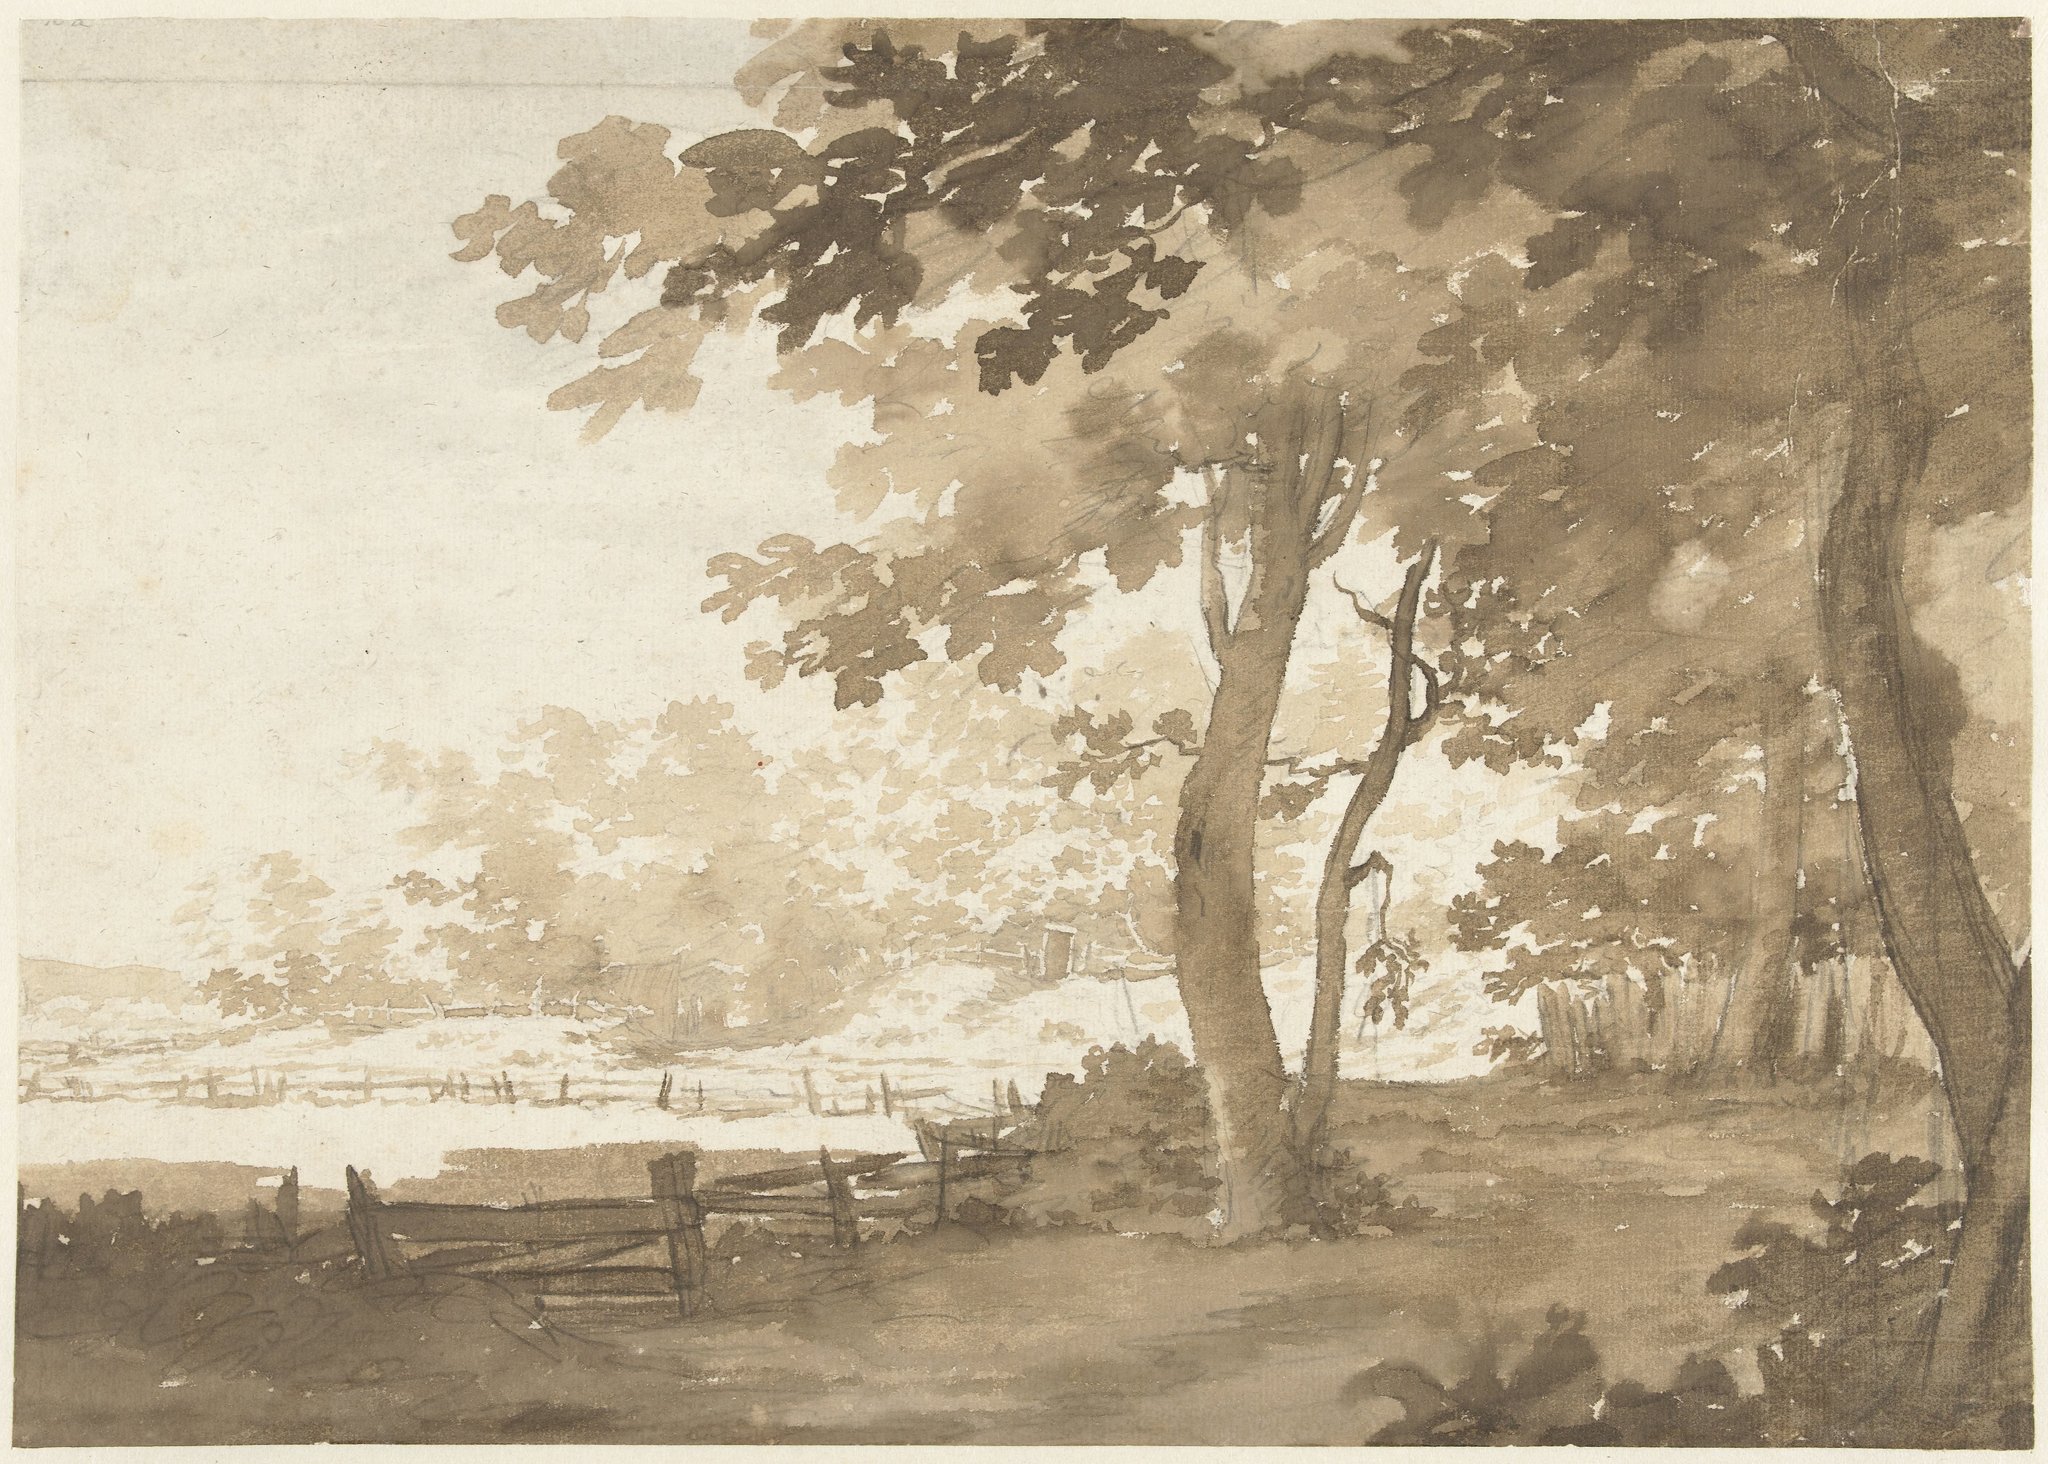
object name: drawing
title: Landschap met een weg onder bomen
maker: jacob cats (1741-1799)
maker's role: draughtsman, print maker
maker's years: 1741-1799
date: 1703-1769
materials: chalk, paper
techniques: brush